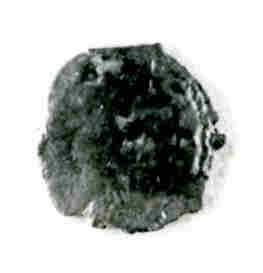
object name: coin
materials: copper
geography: iran